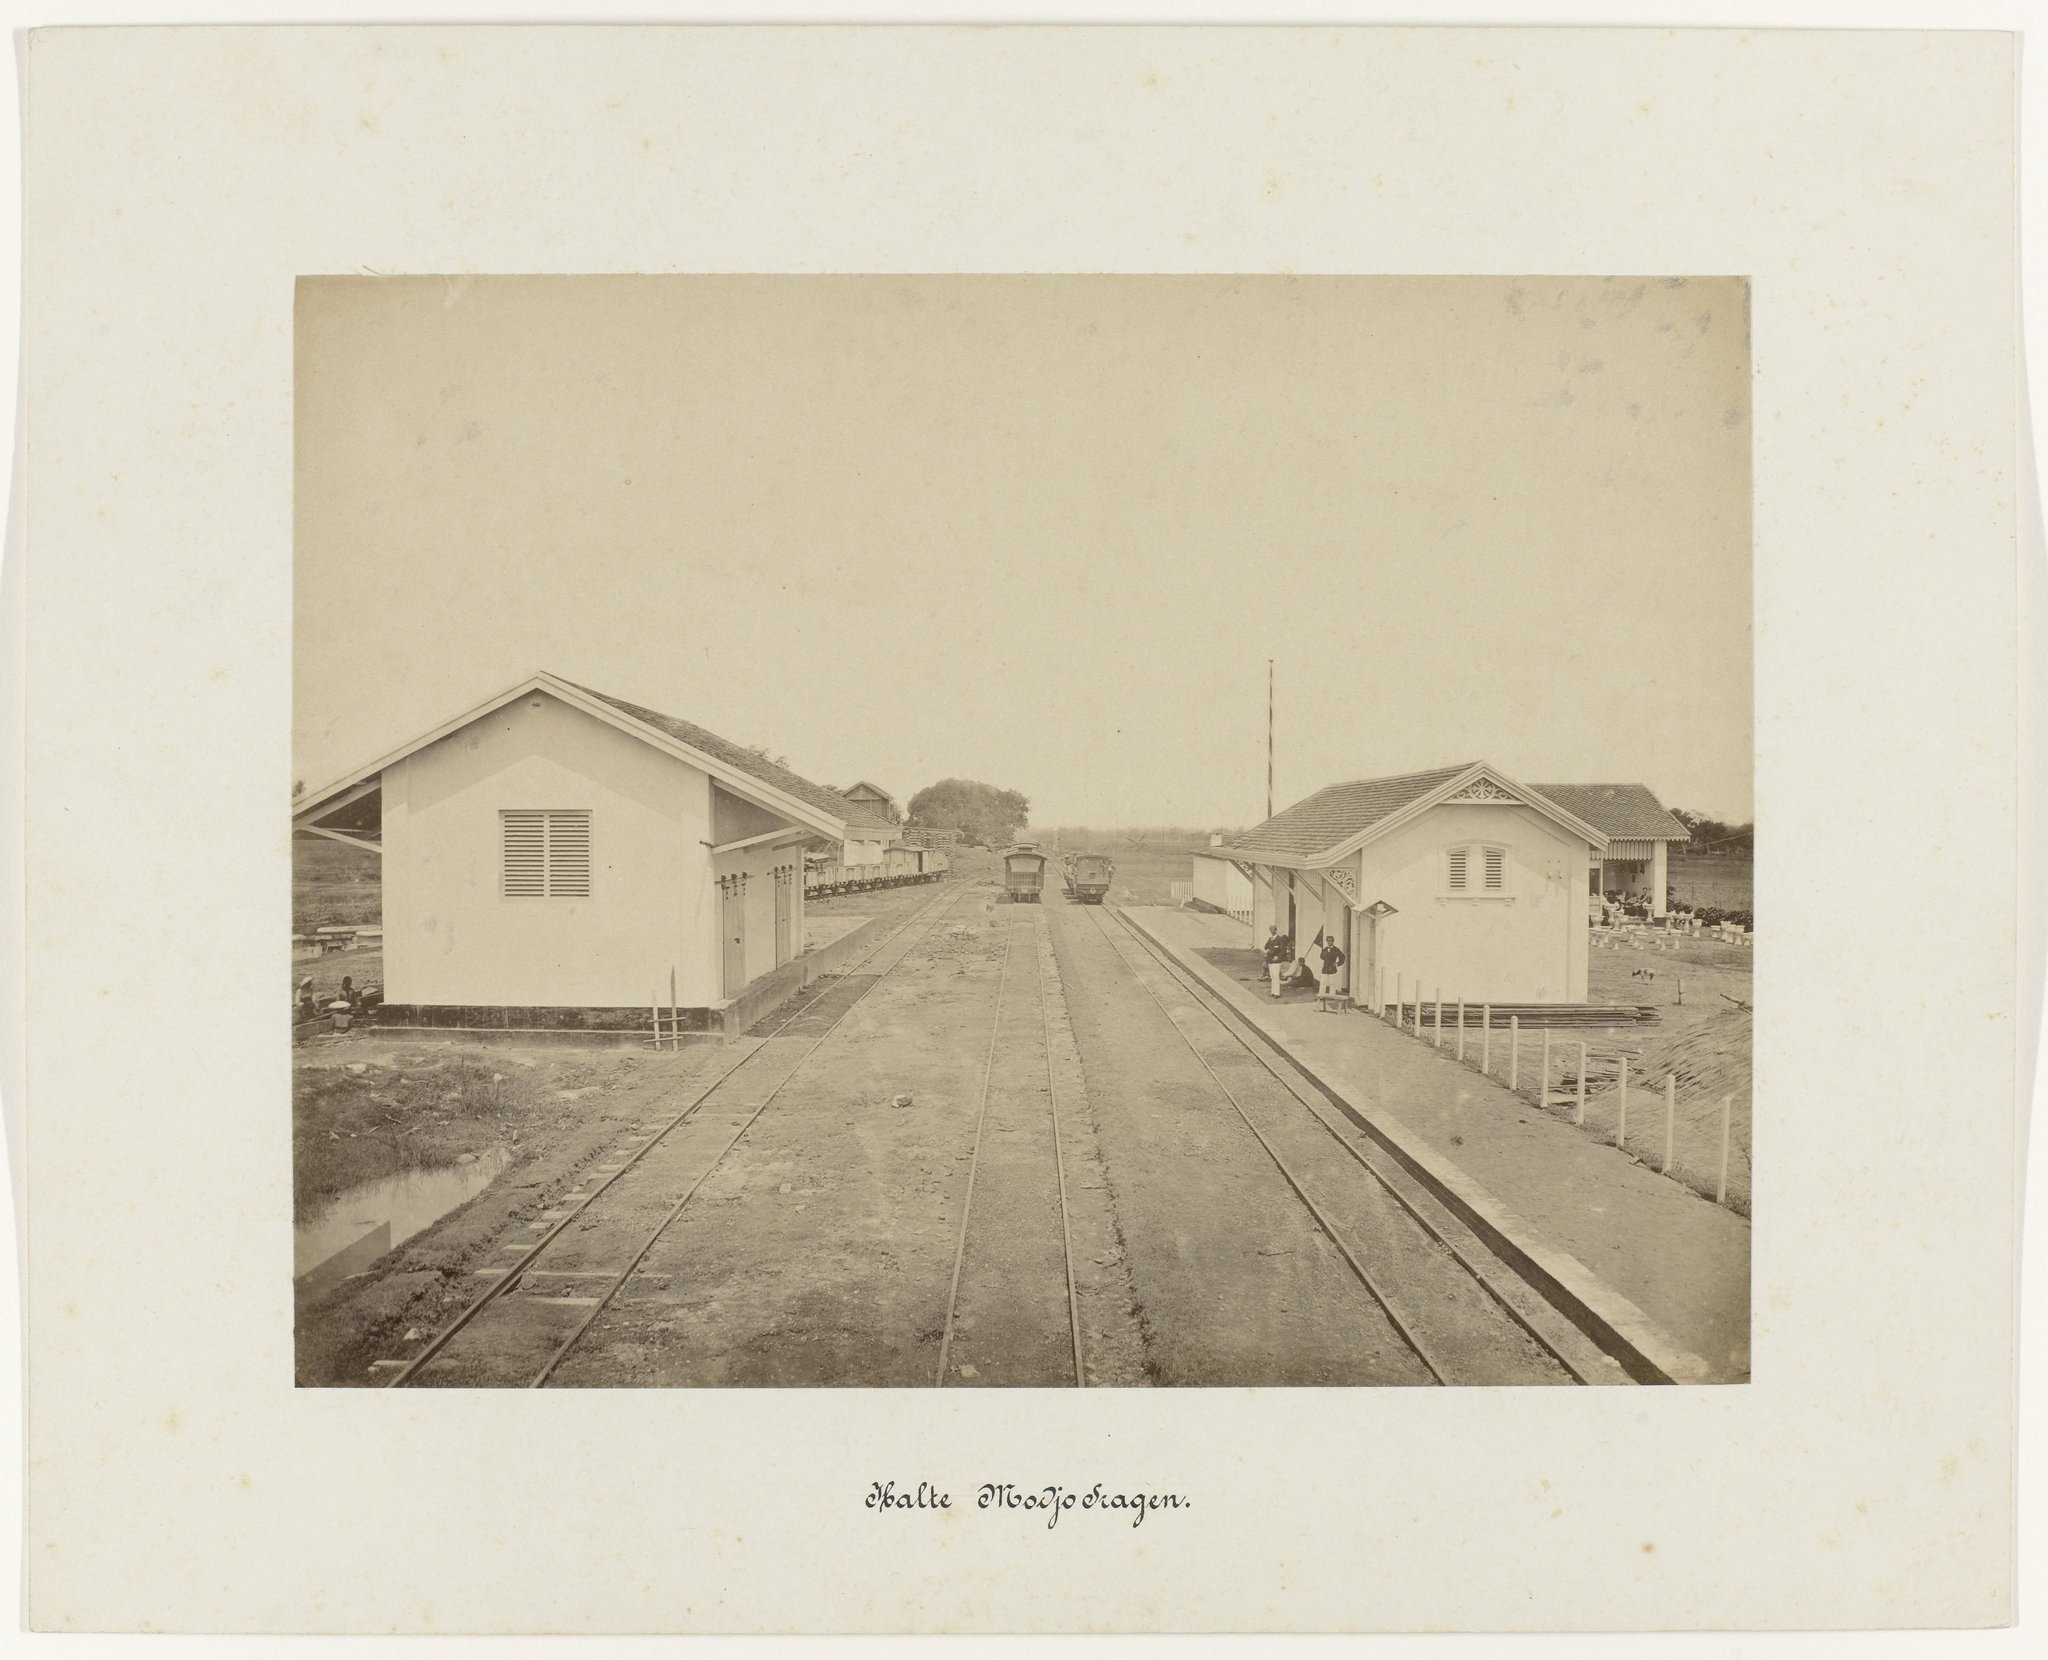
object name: photograph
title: Halte Modjodragen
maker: Anonymous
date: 1880-1888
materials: photographic support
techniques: albumen print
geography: java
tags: java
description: De halte Modjodragen, op de sporen bij het station enkele treinwagons. Onderdeel van een groep van 62 foto's in een doos met het opschrift "Staatsspoorwegen op Java" uit 1888.